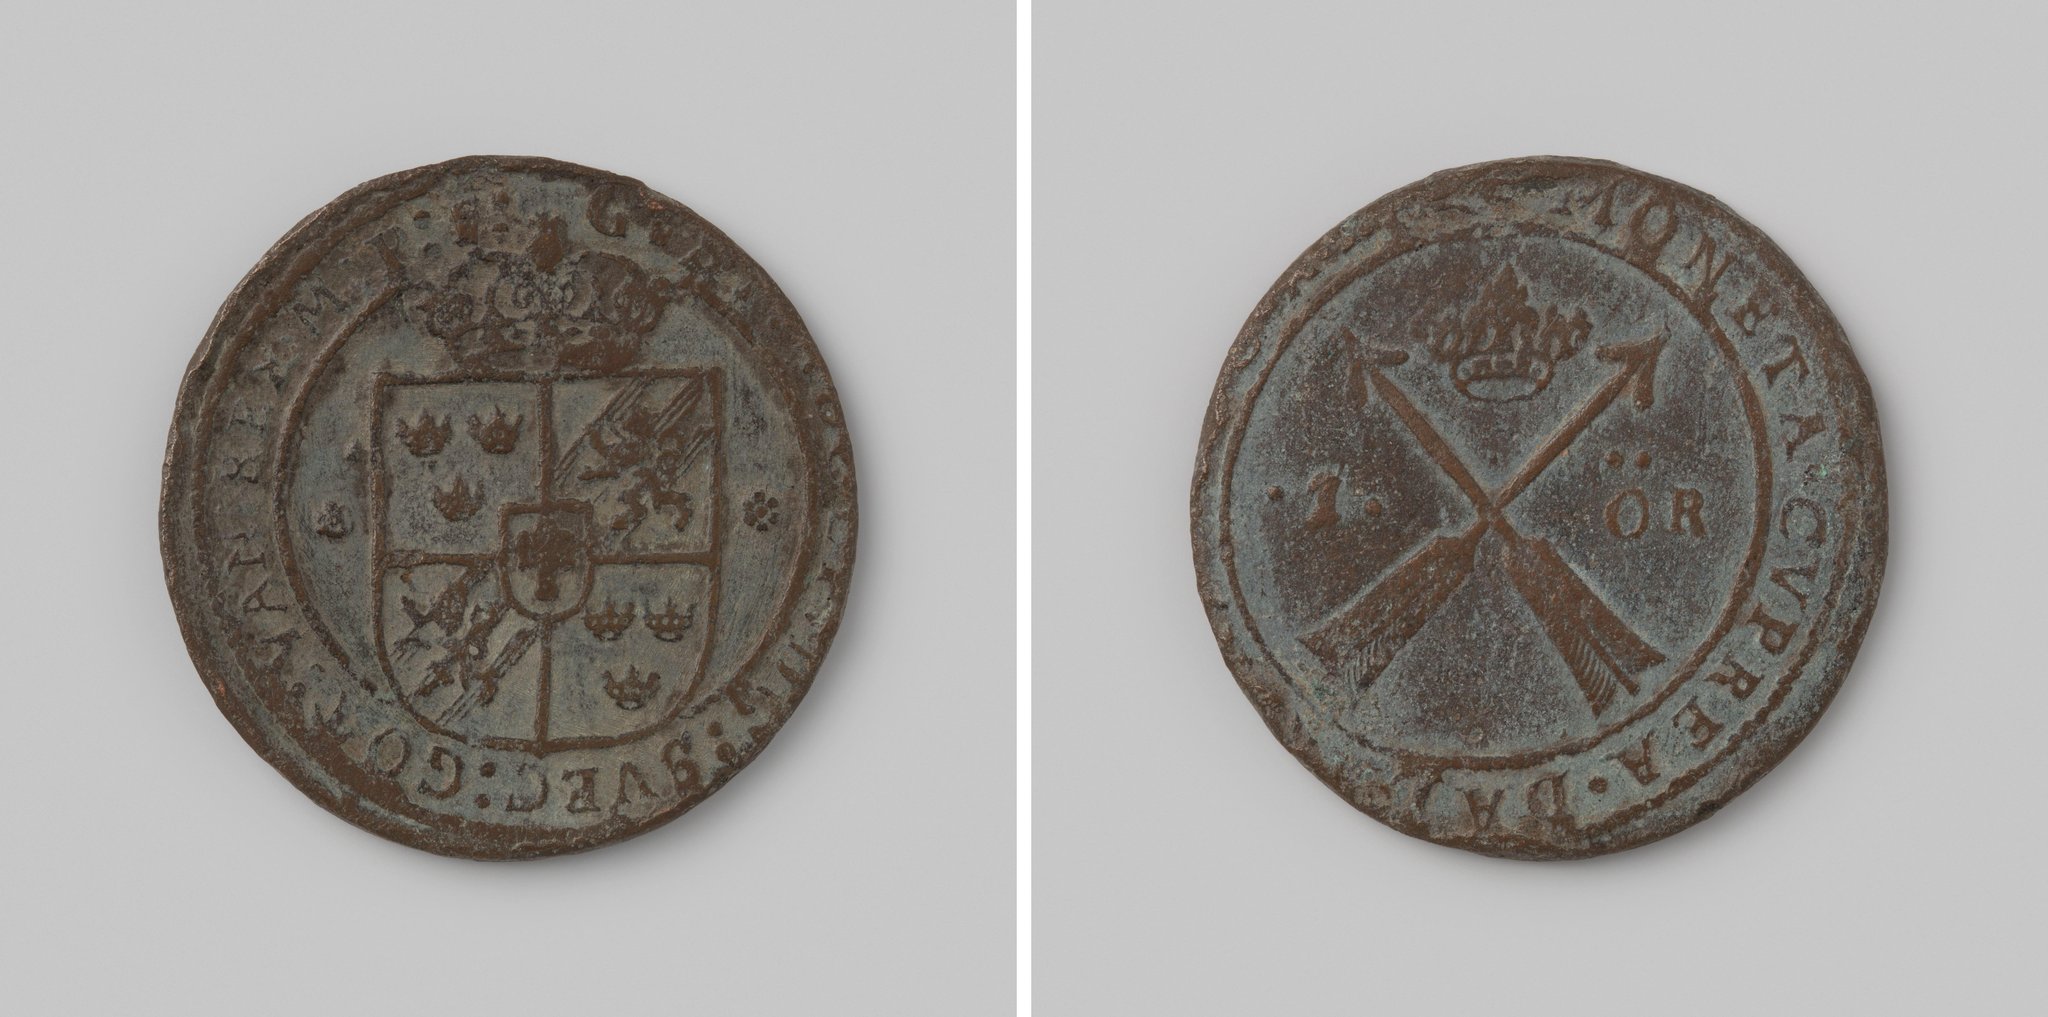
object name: coin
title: Zweden, Gustaf II Adolf, öre voor het landschap Dalarne,1622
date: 1622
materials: copper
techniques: striking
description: Koperen munt. Voorzijde: gekroond samengesteld wapenschild. Keerzijde: twee gekruiste pijlen, waarboven kroon. Waarde-aanduiding 1 ör in veld. Jaartal in omschrft. Gladde rand.